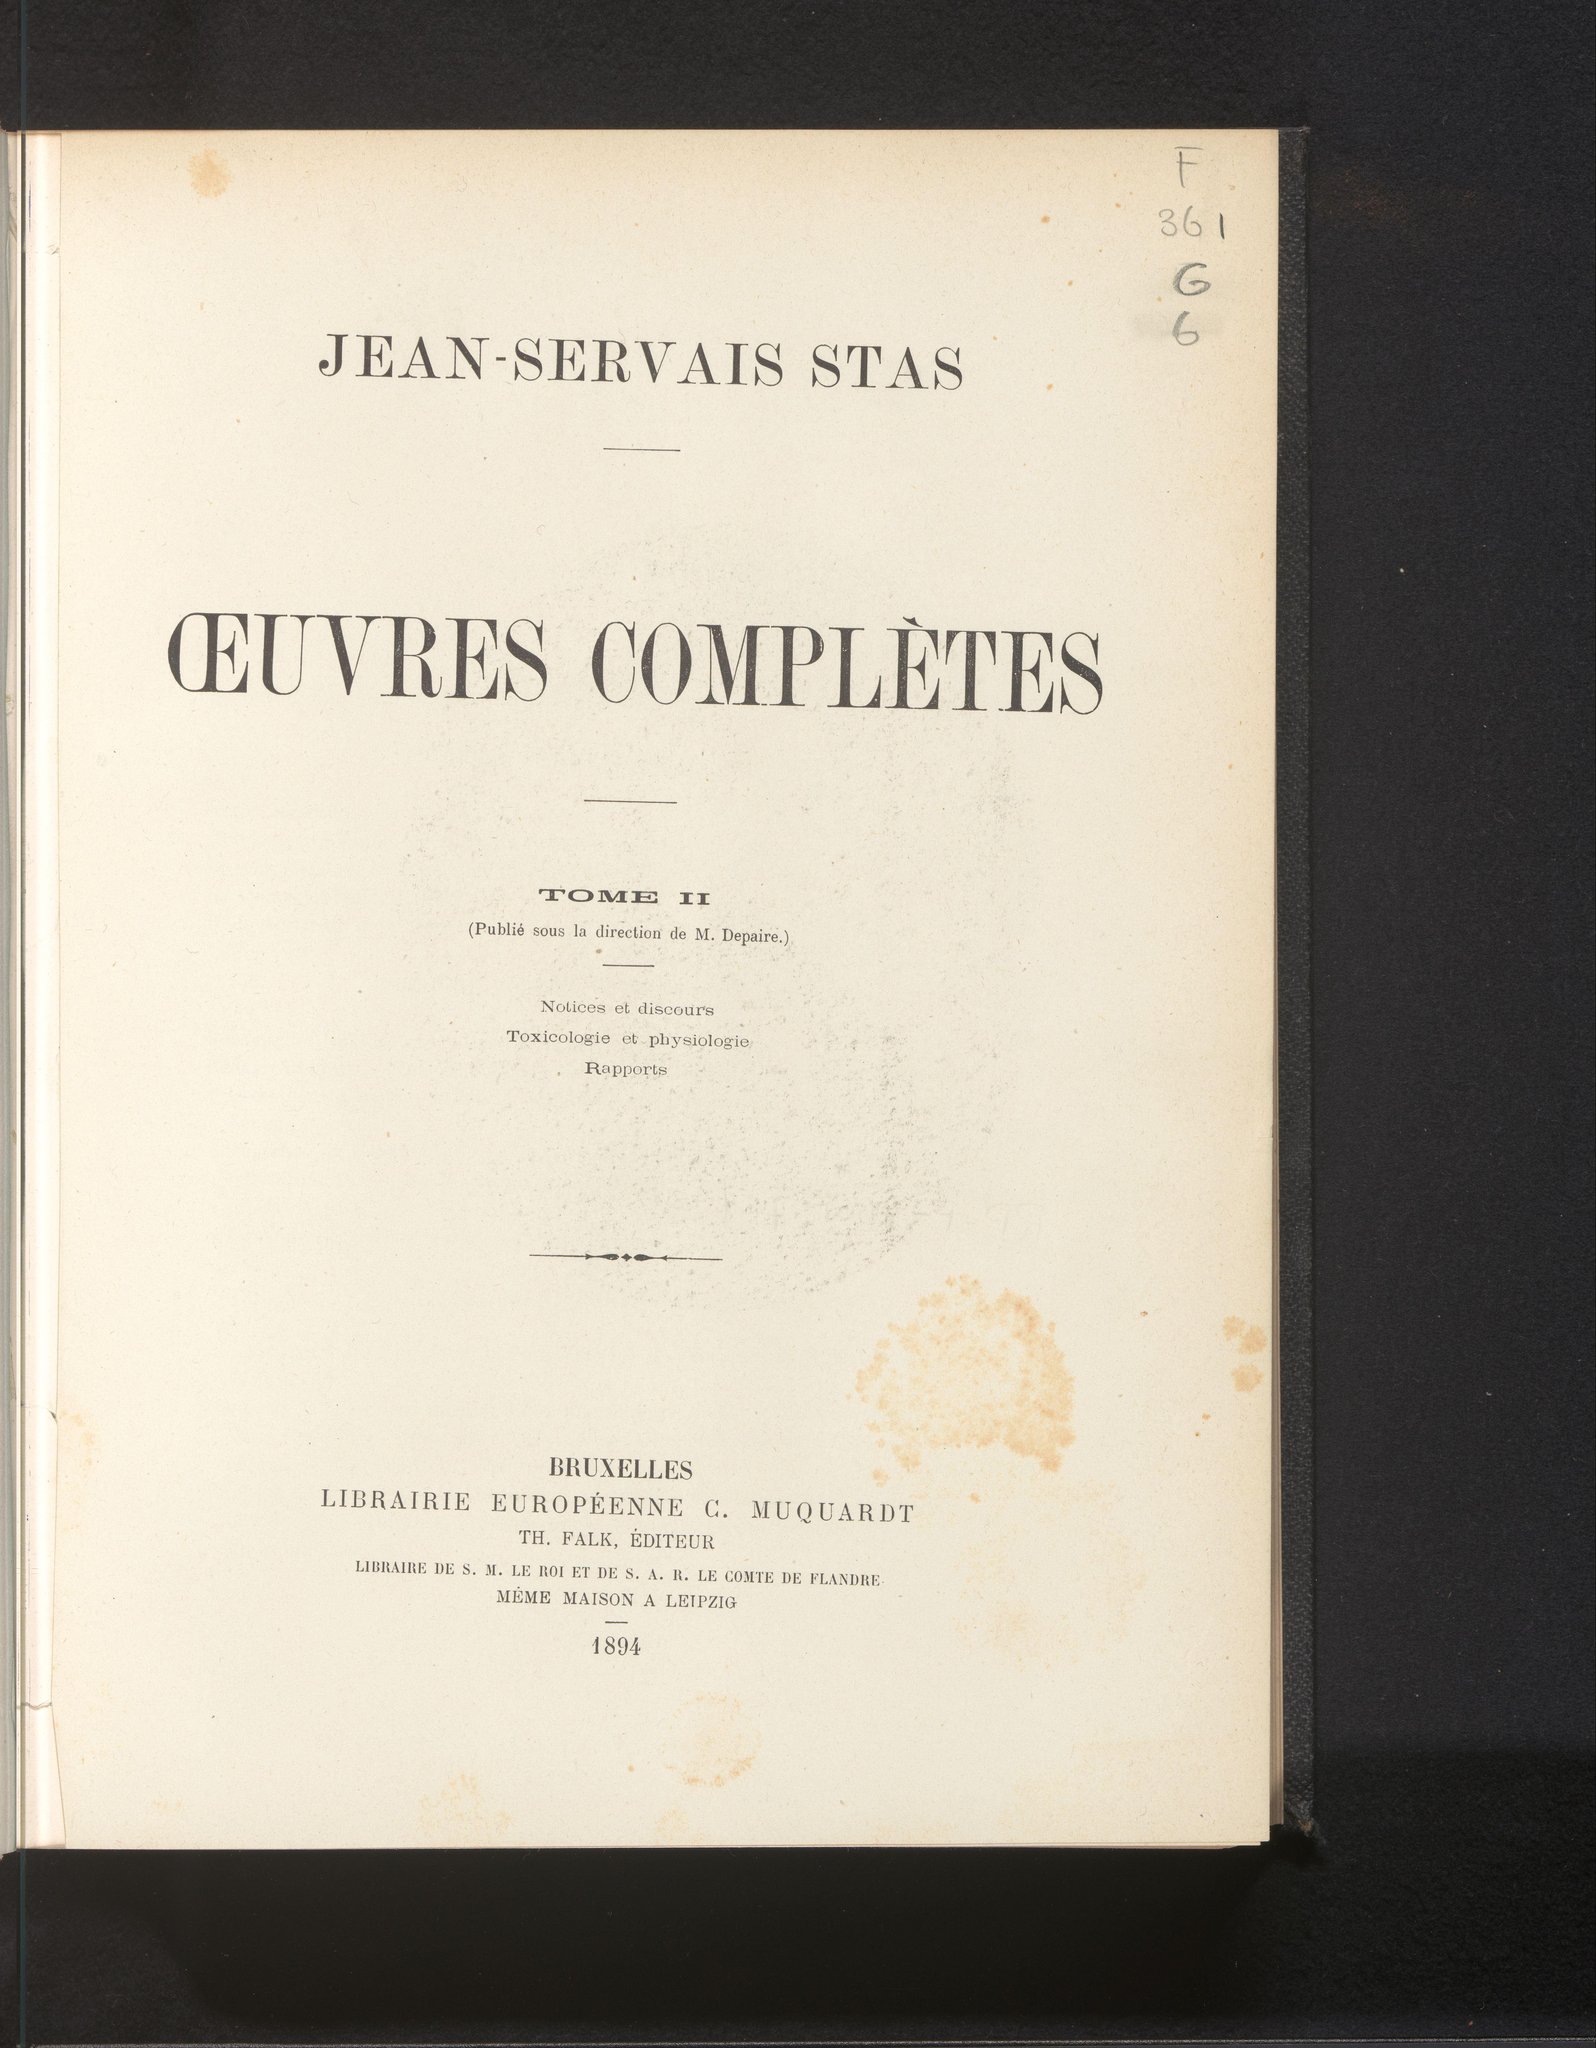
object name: book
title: Oeuvres complètes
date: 1894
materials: linen, paper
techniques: decorated paper, photoaquatint, printing, engraving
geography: brussels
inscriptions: date: ‘Dec 1990’